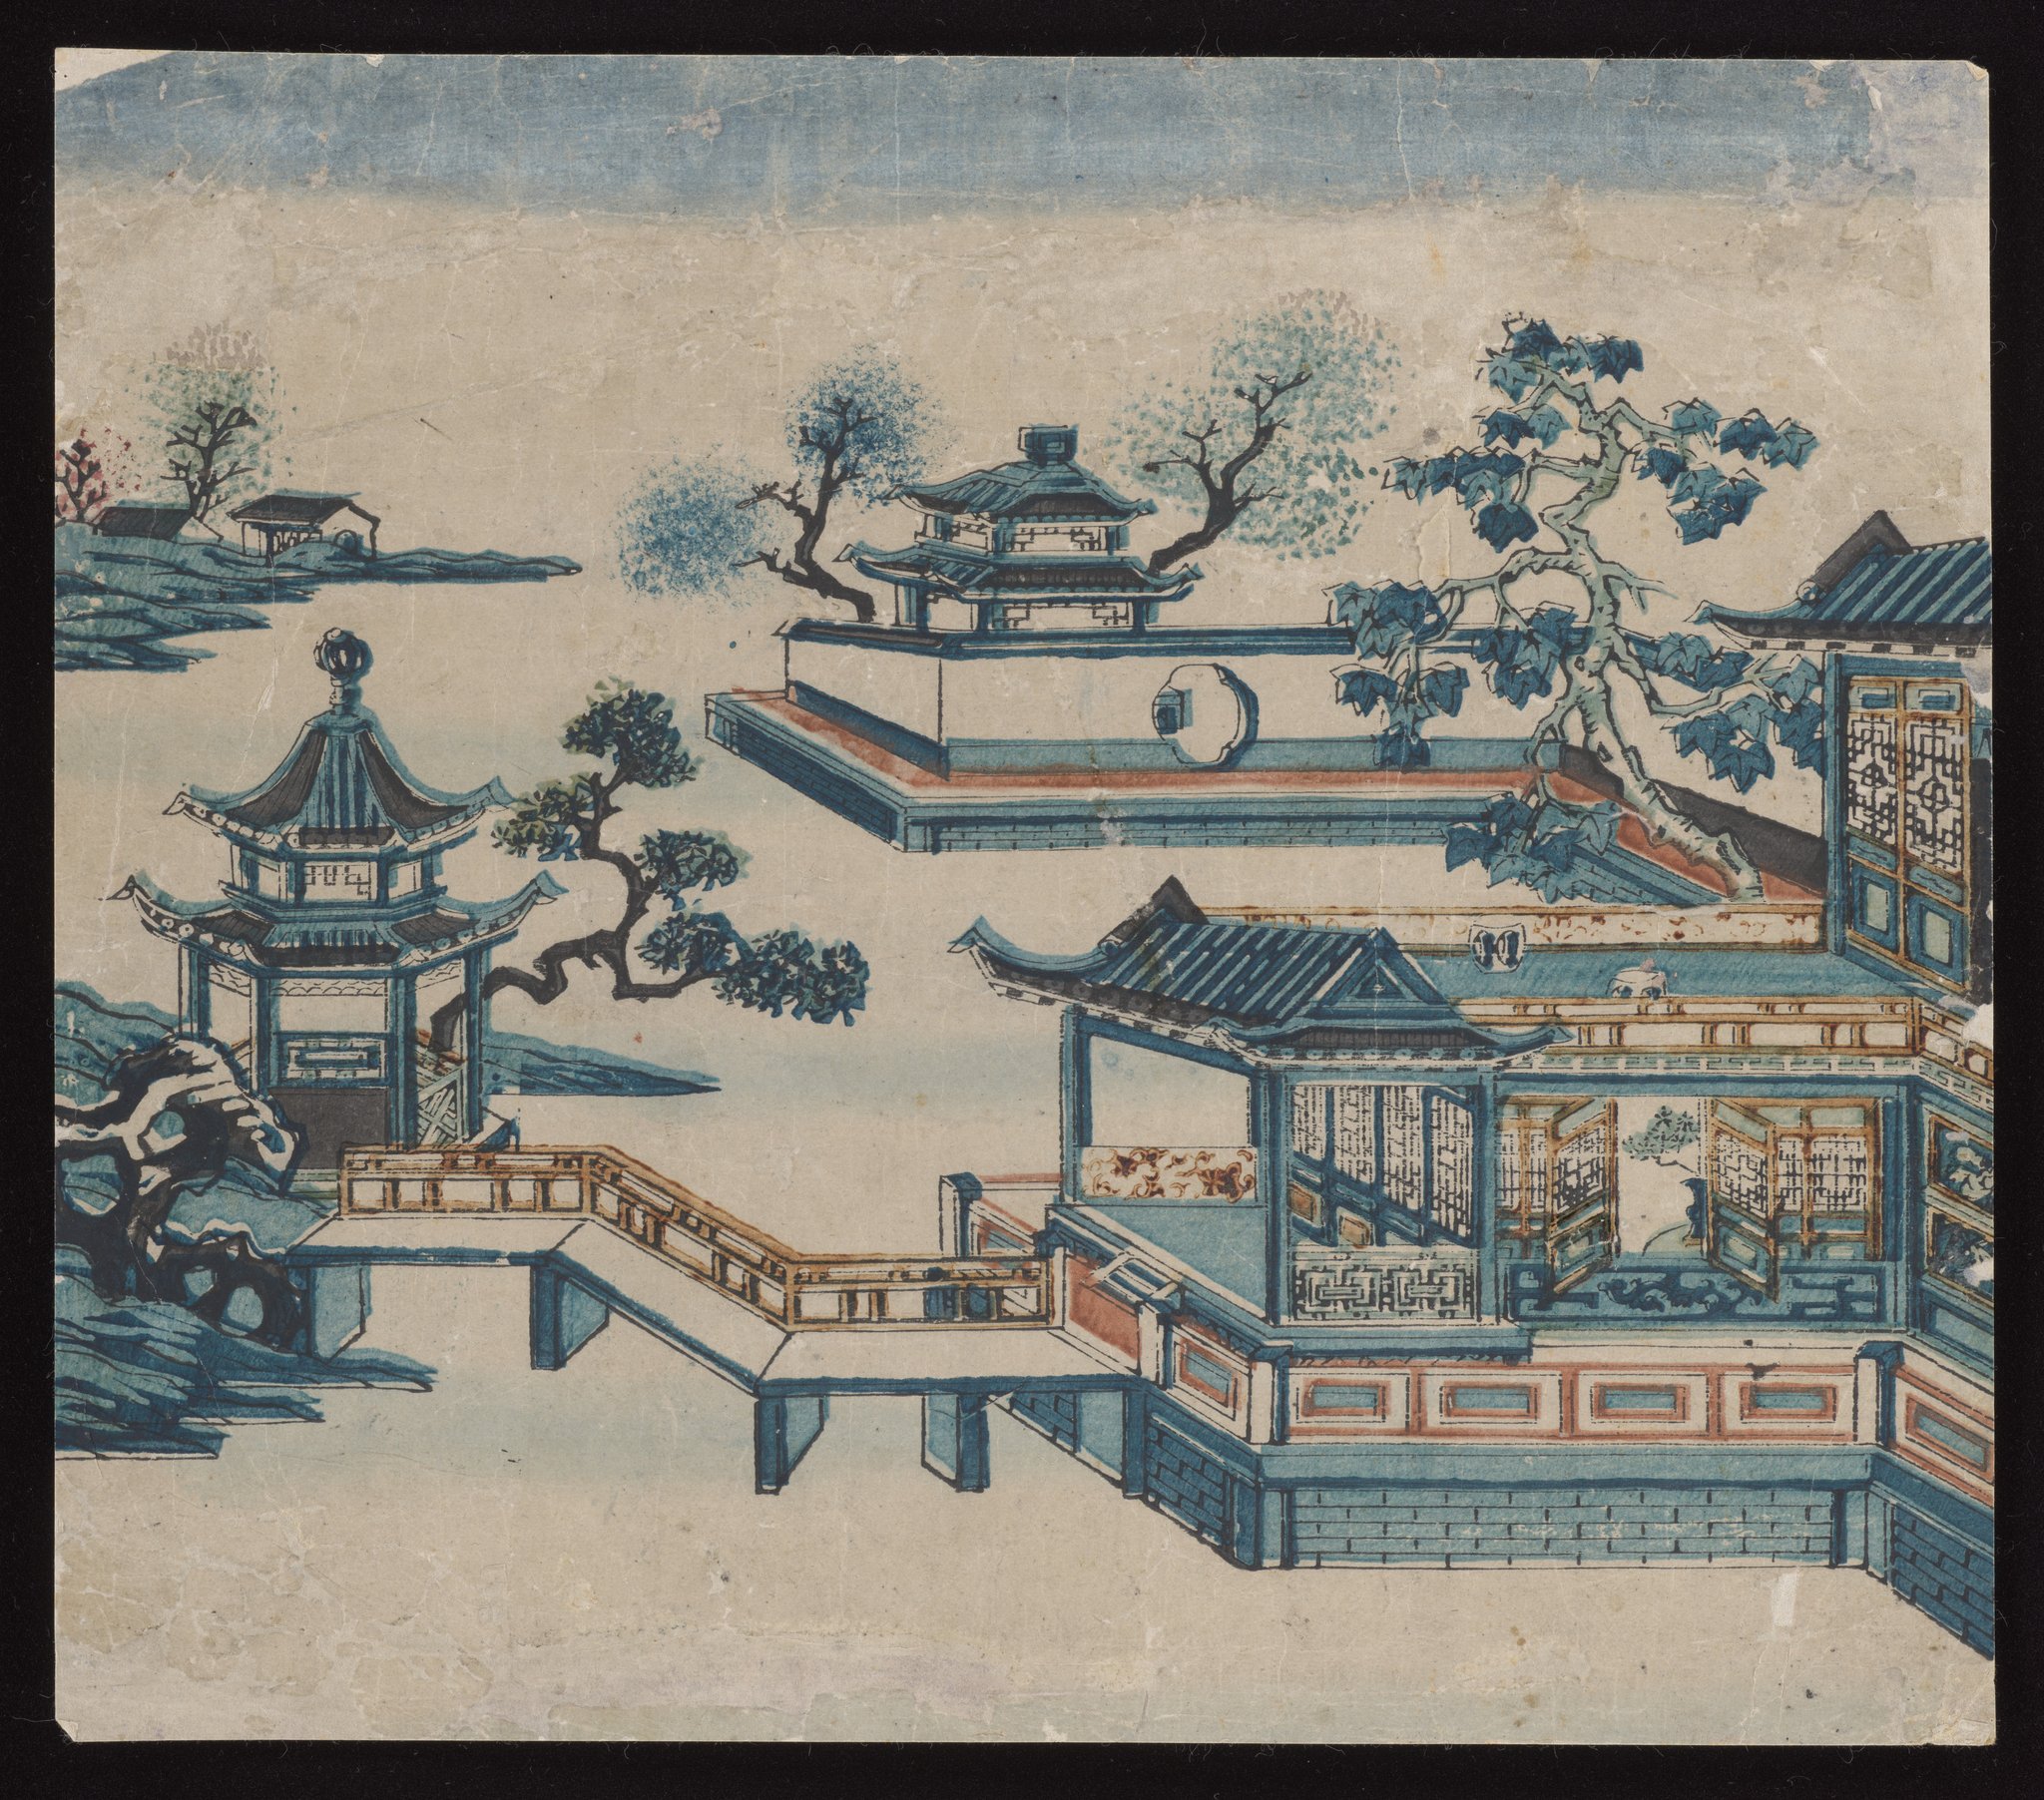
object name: print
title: Scenic Spots of Zhenjiang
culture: chinese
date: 1736-1795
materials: ink, paper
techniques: hand coloring, woodblock print